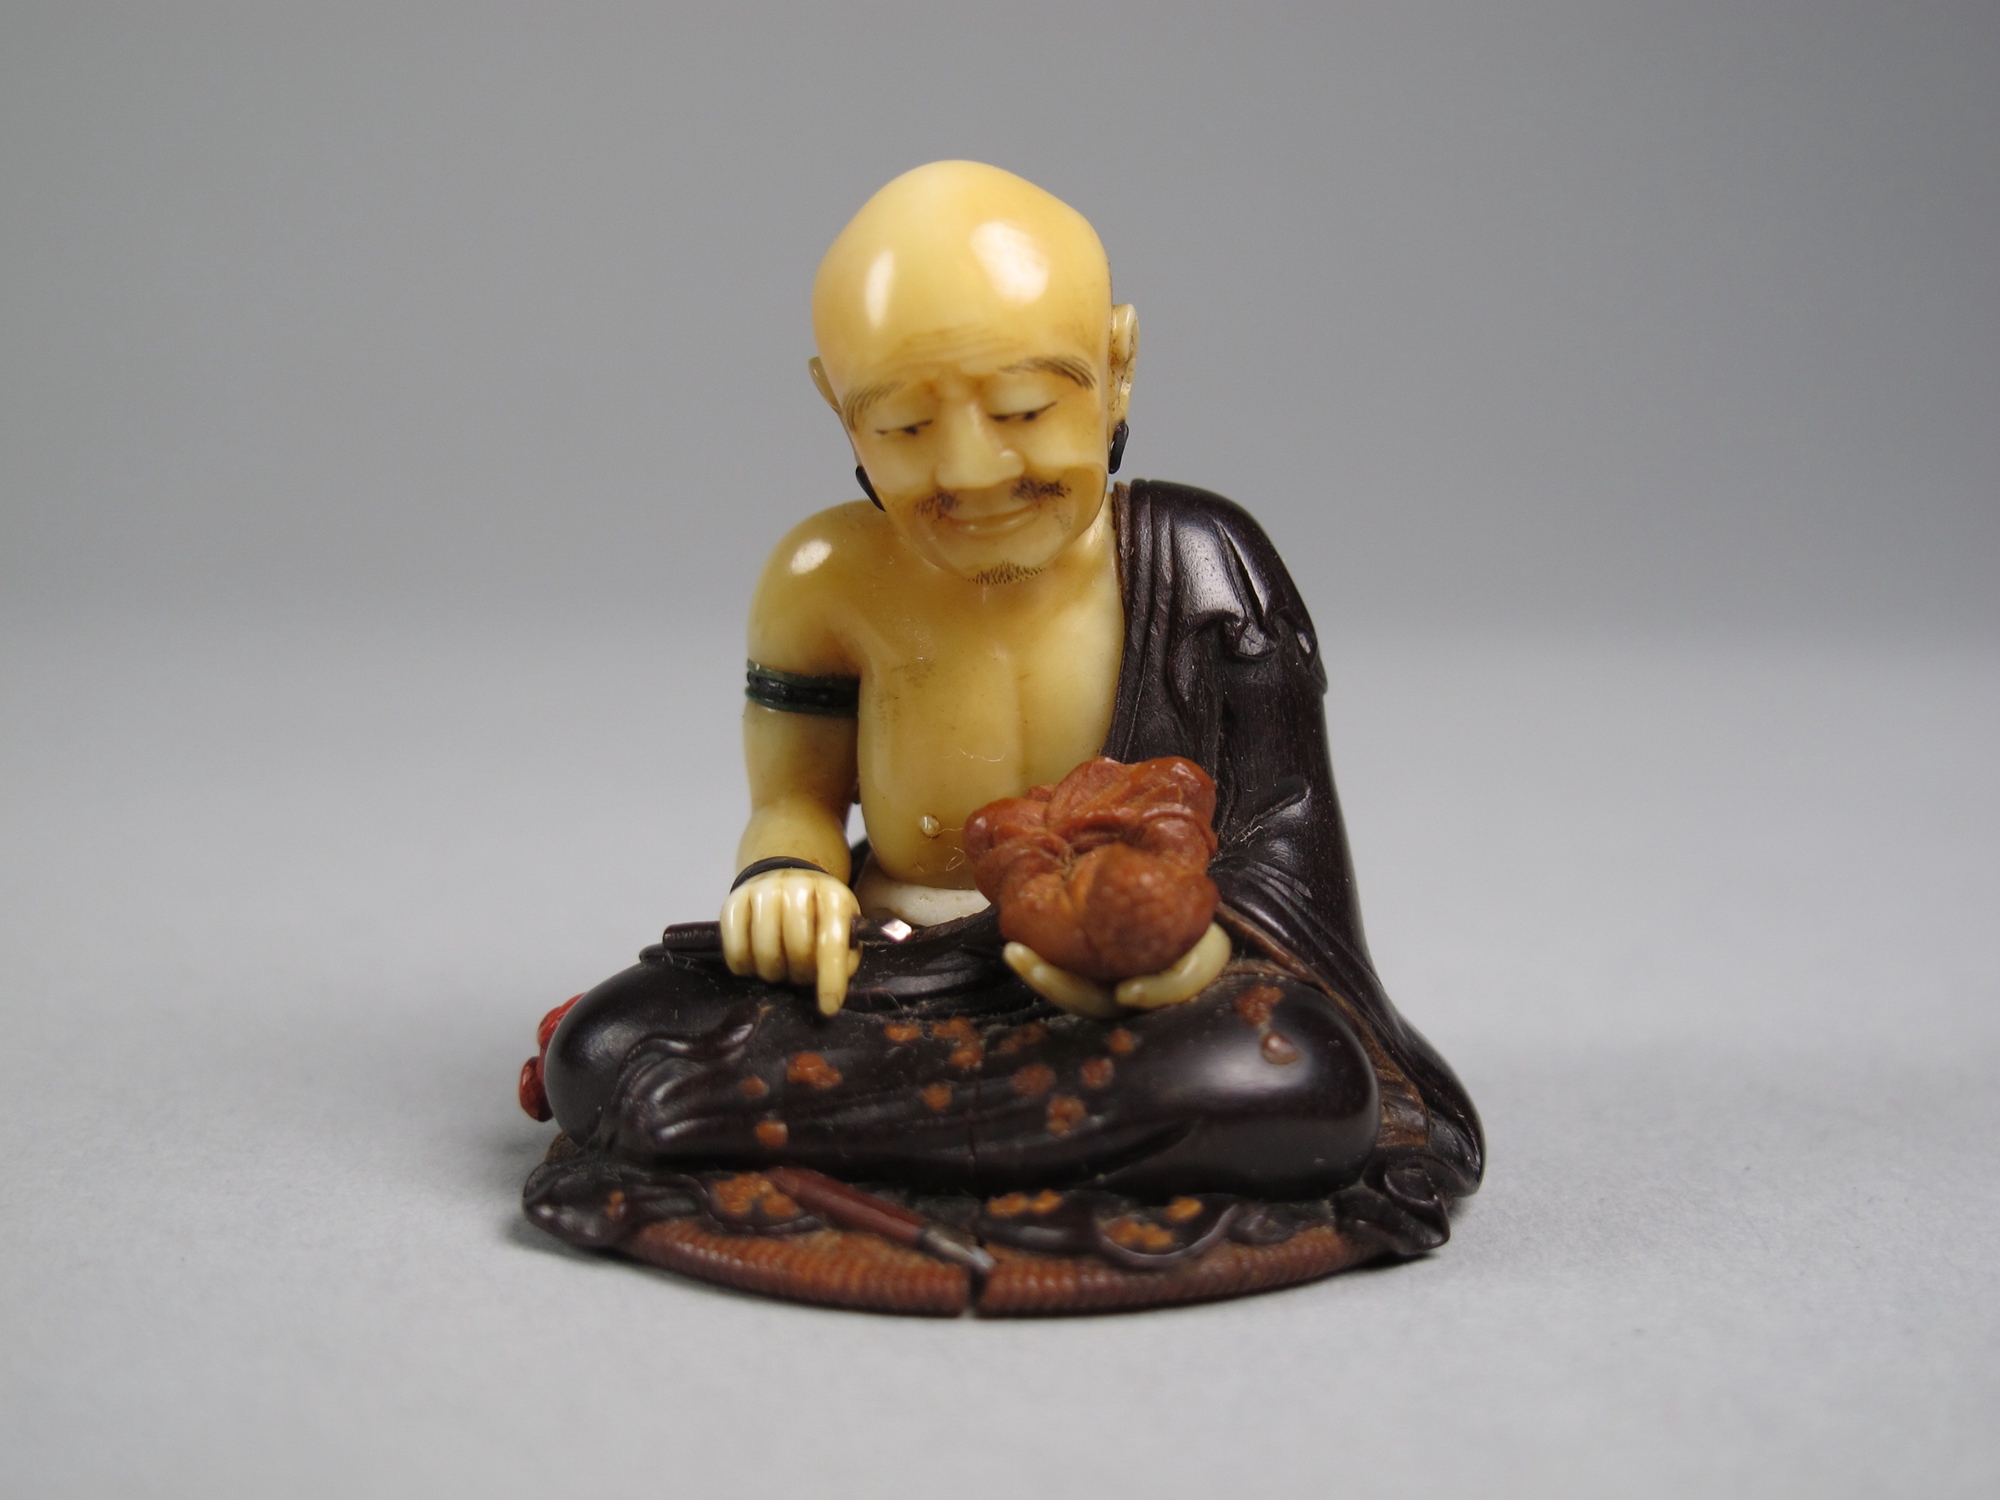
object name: netsuke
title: Netsuke of Wood Carver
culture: japanese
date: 1801-1900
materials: ivory, wood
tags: men